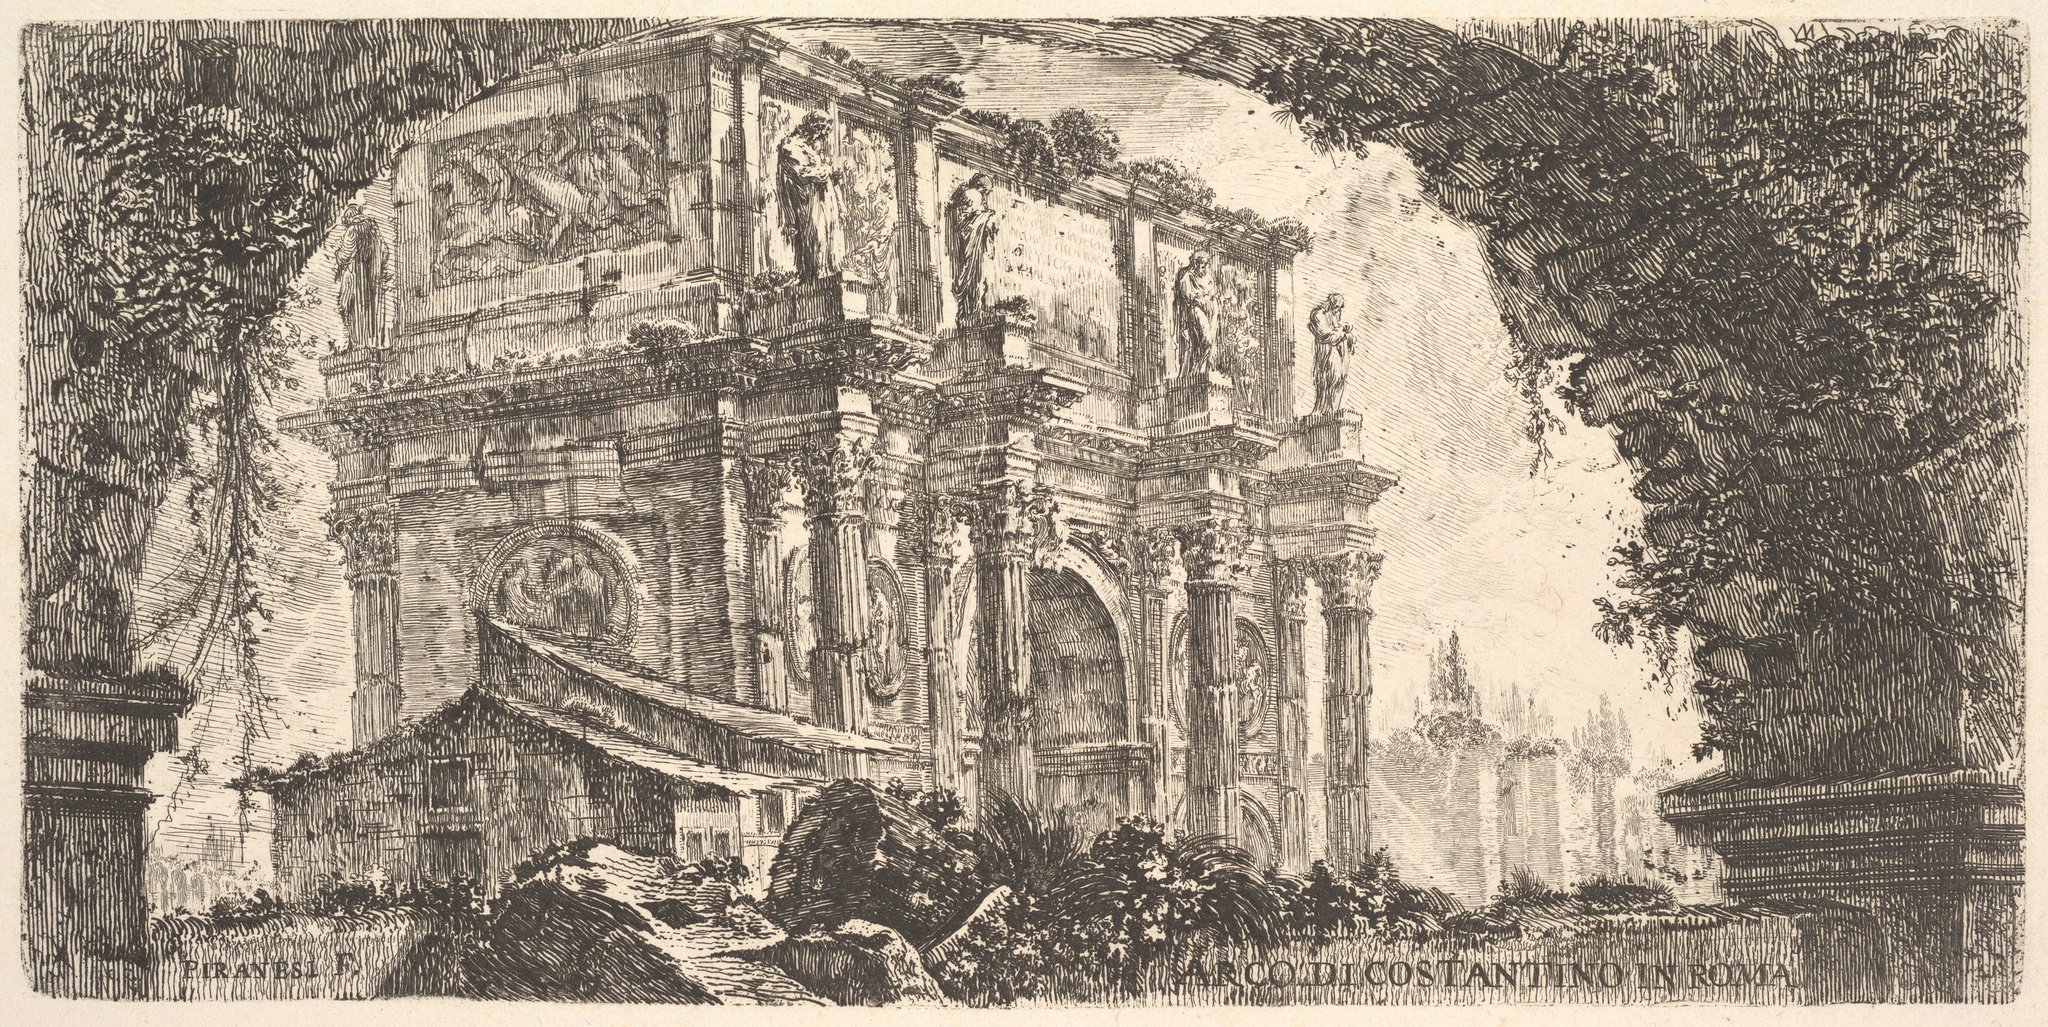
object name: print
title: Plate 9: Arch of Constantine in Rome (Arco di Costantino in Roma), from "Antichità Romane de' Tempi della Repubblica, e de' primi Imperatori"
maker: giovanni battista piranesi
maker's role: artist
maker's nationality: italian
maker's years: 1720-1778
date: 1748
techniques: etching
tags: arches,buildings,rome